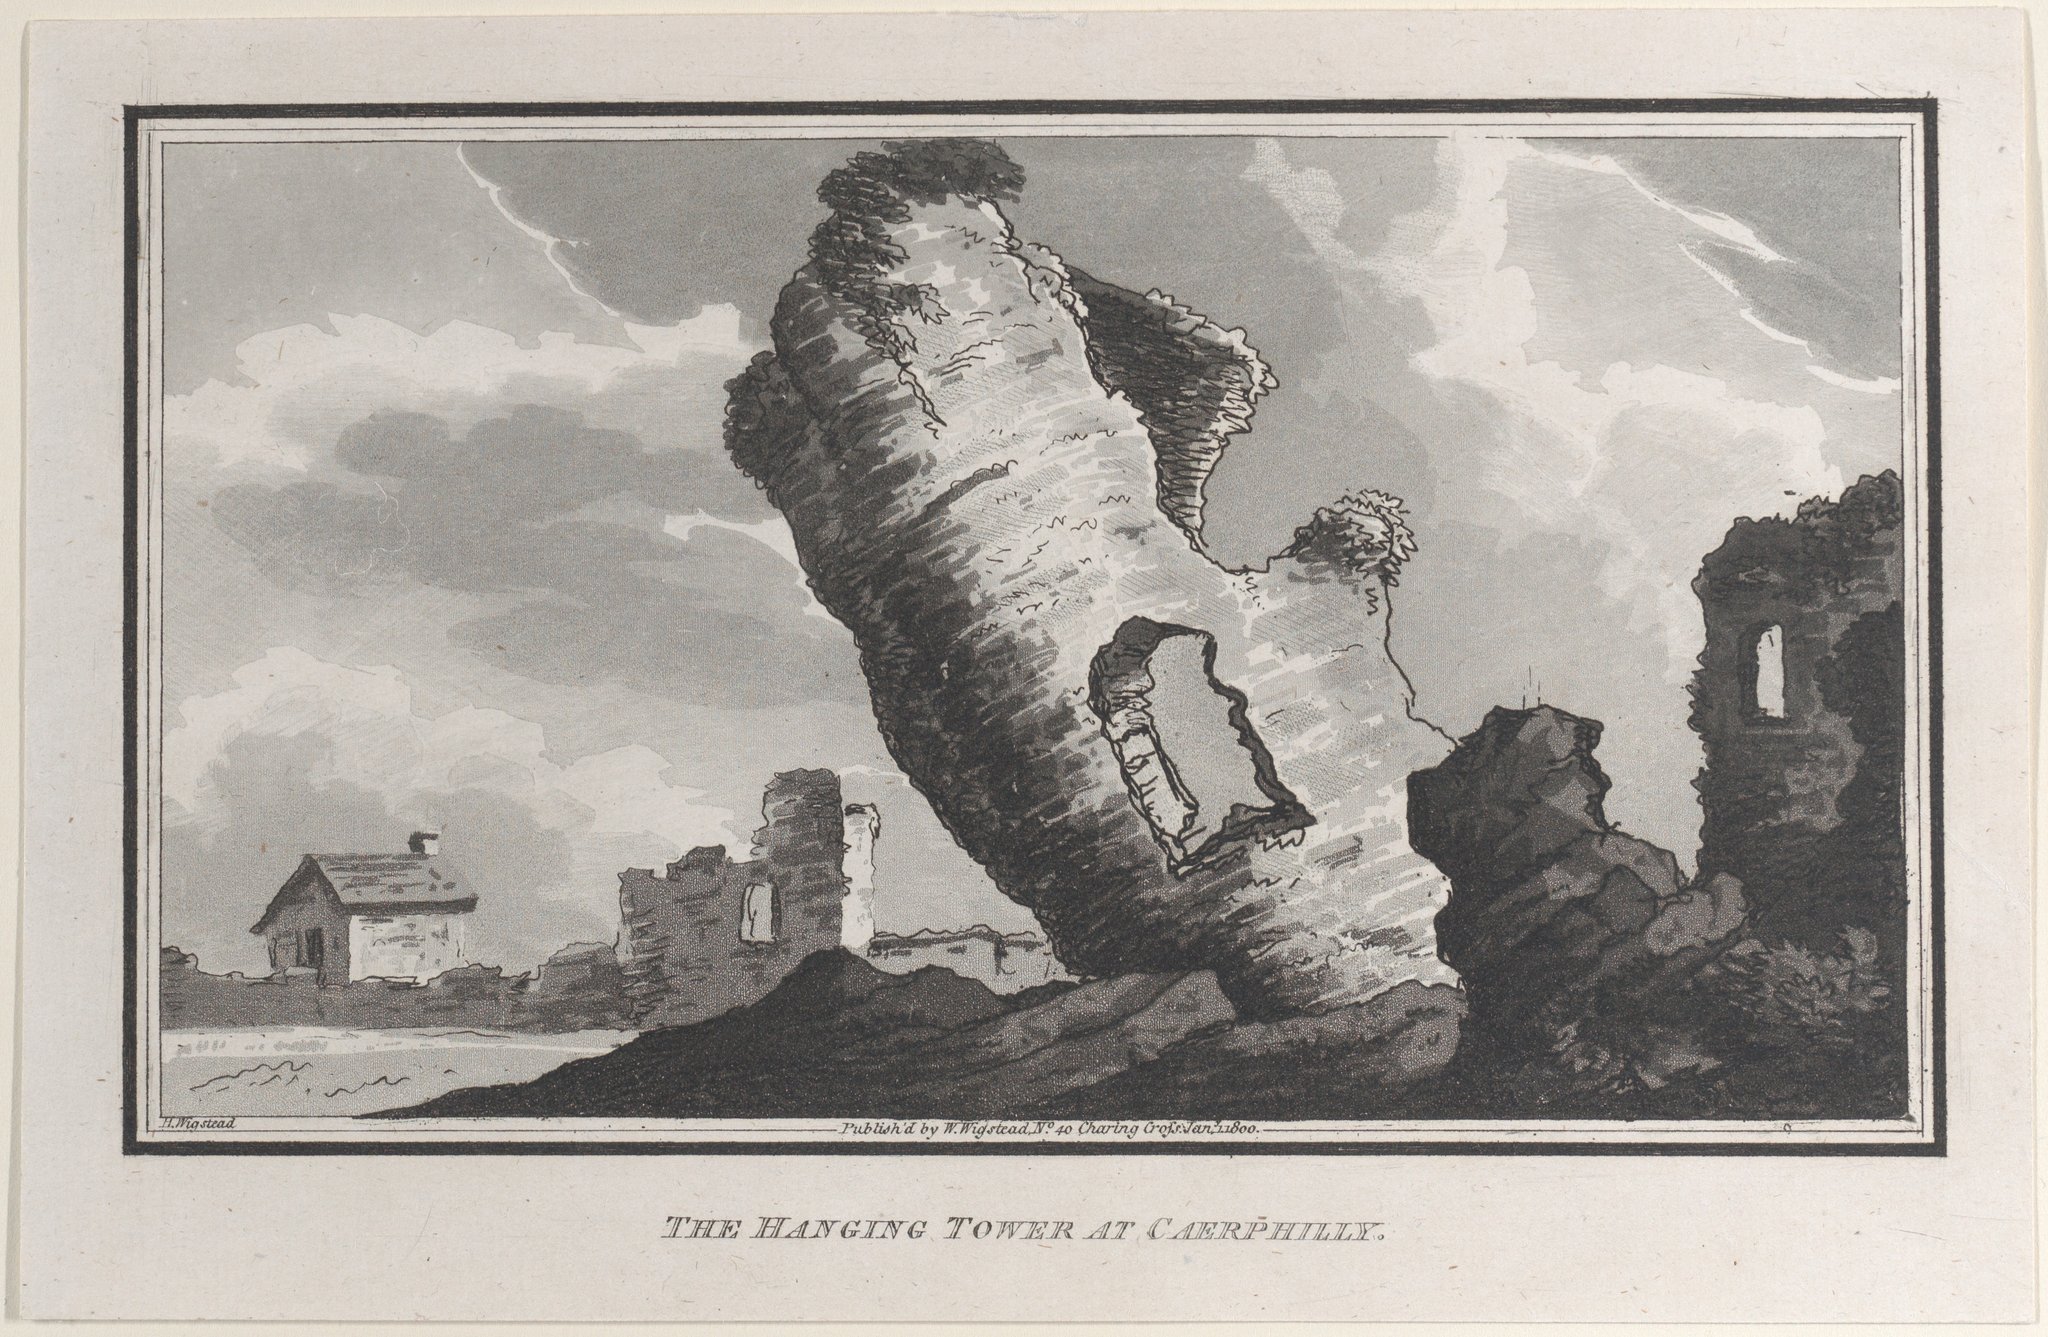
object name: print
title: The Hanging Tower at Caerphilly, from "Remarks on a Tour to North and South Wales, in the year 1797"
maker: john hill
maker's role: artist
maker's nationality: british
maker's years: 1714-1775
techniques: aquatint, etching